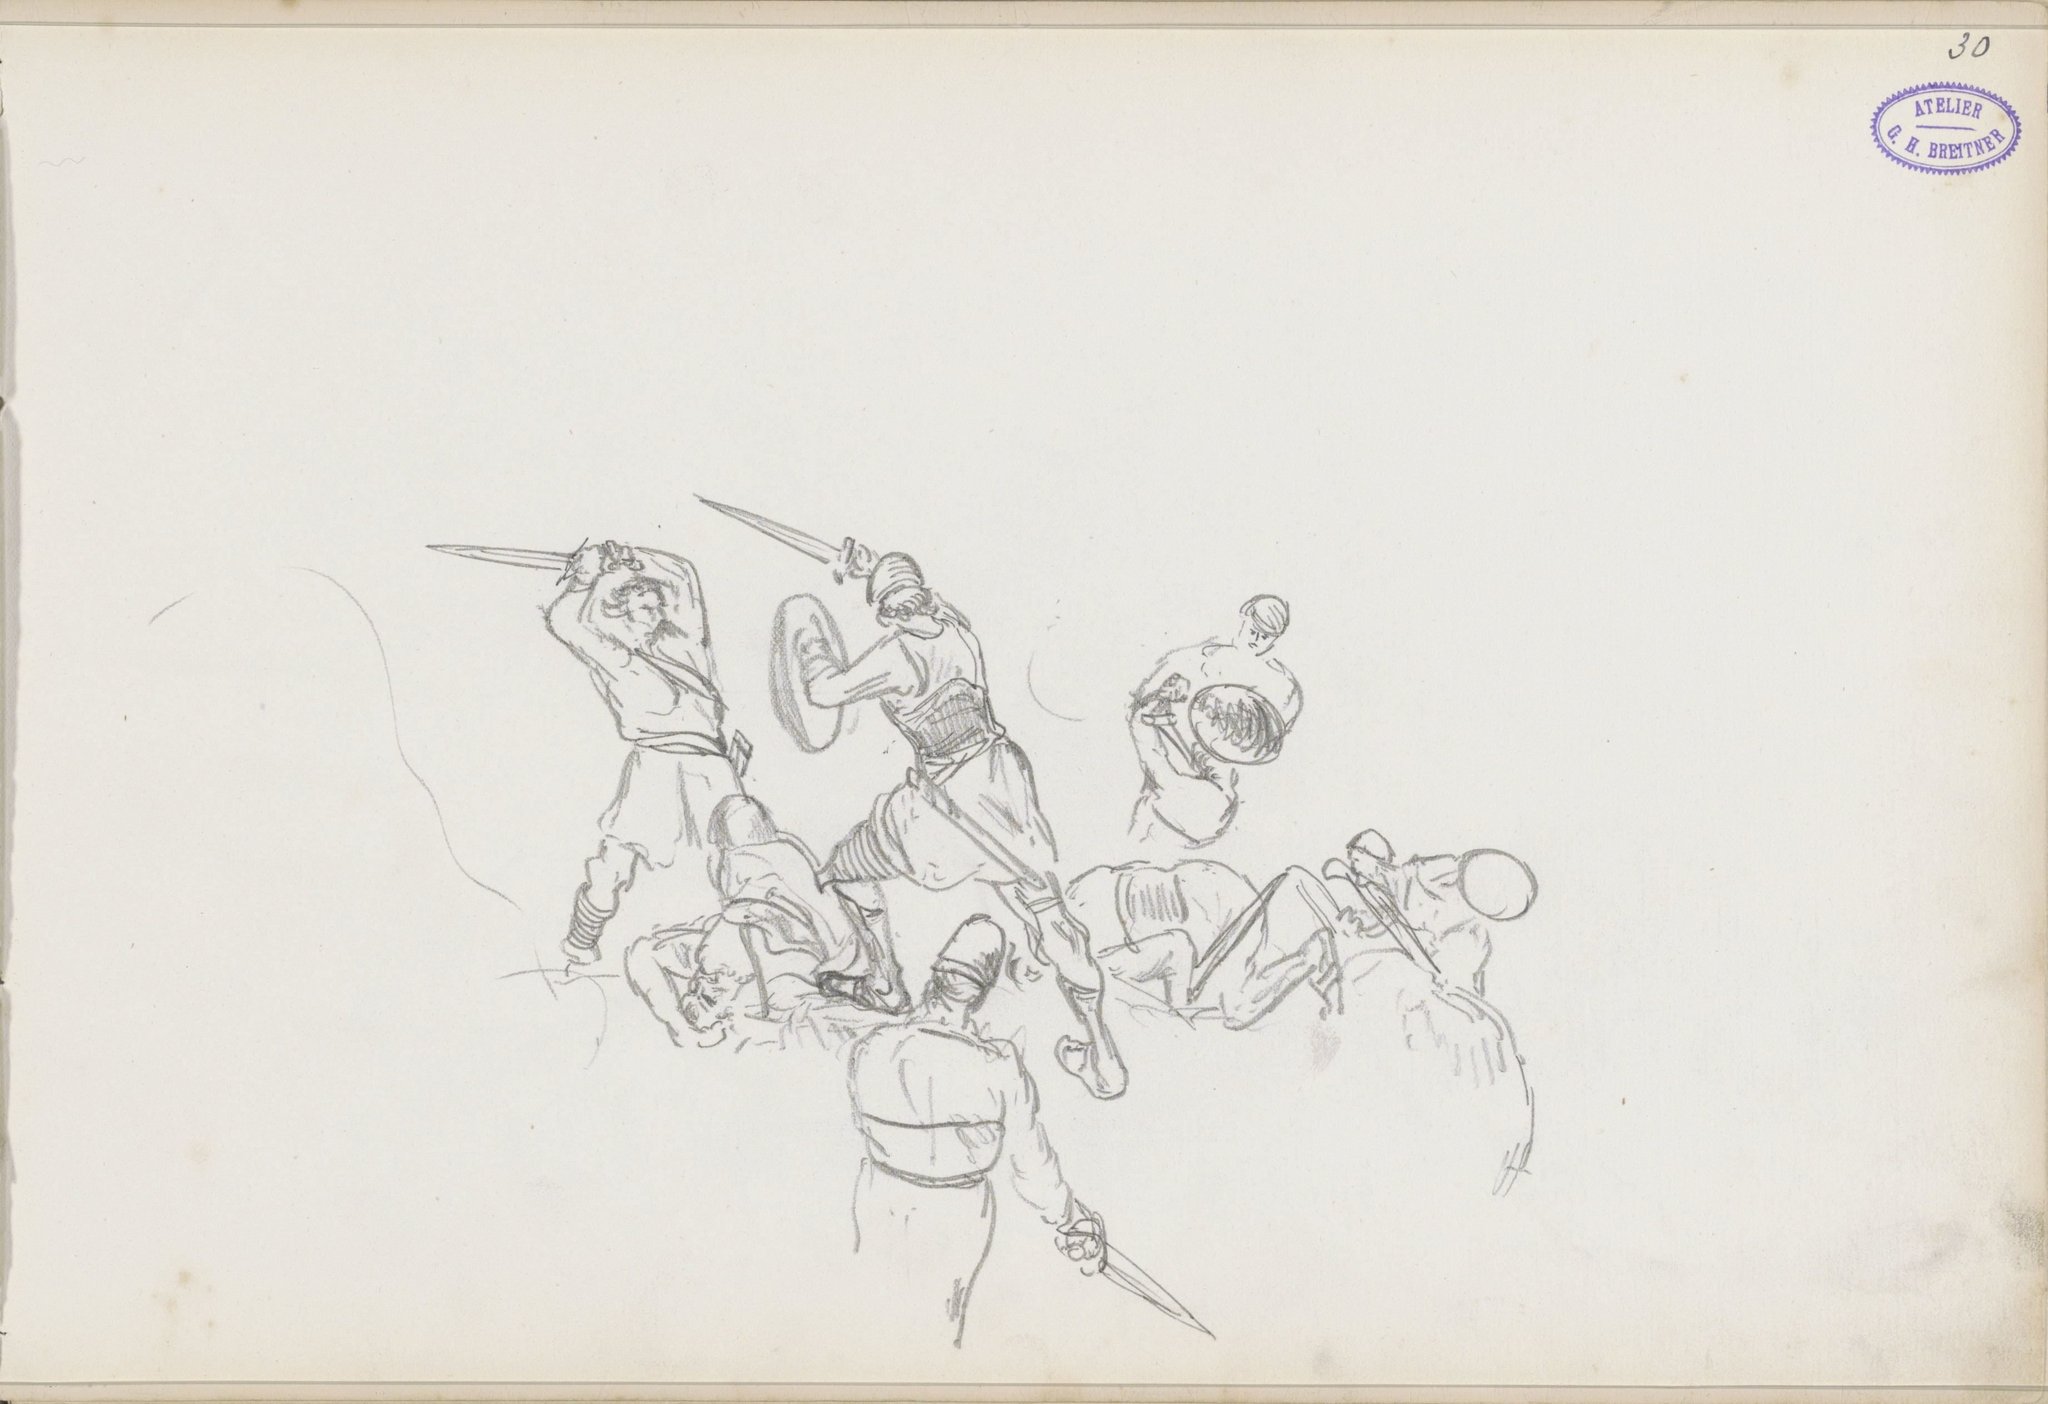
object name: sketchbook leaf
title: Strijdende soldaten met zwaarden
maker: george hendrik breitner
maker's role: draughtsman, painter, print maker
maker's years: 1857-1923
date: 1809-1872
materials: paper, pencil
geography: rotterdam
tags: division of armed forces (+ during the battle), hacking and thrusting weapons: sword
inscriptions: workshop stamp: Lugt 291d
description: Blad 30 recto uit een schetsboek met 32 bladen.